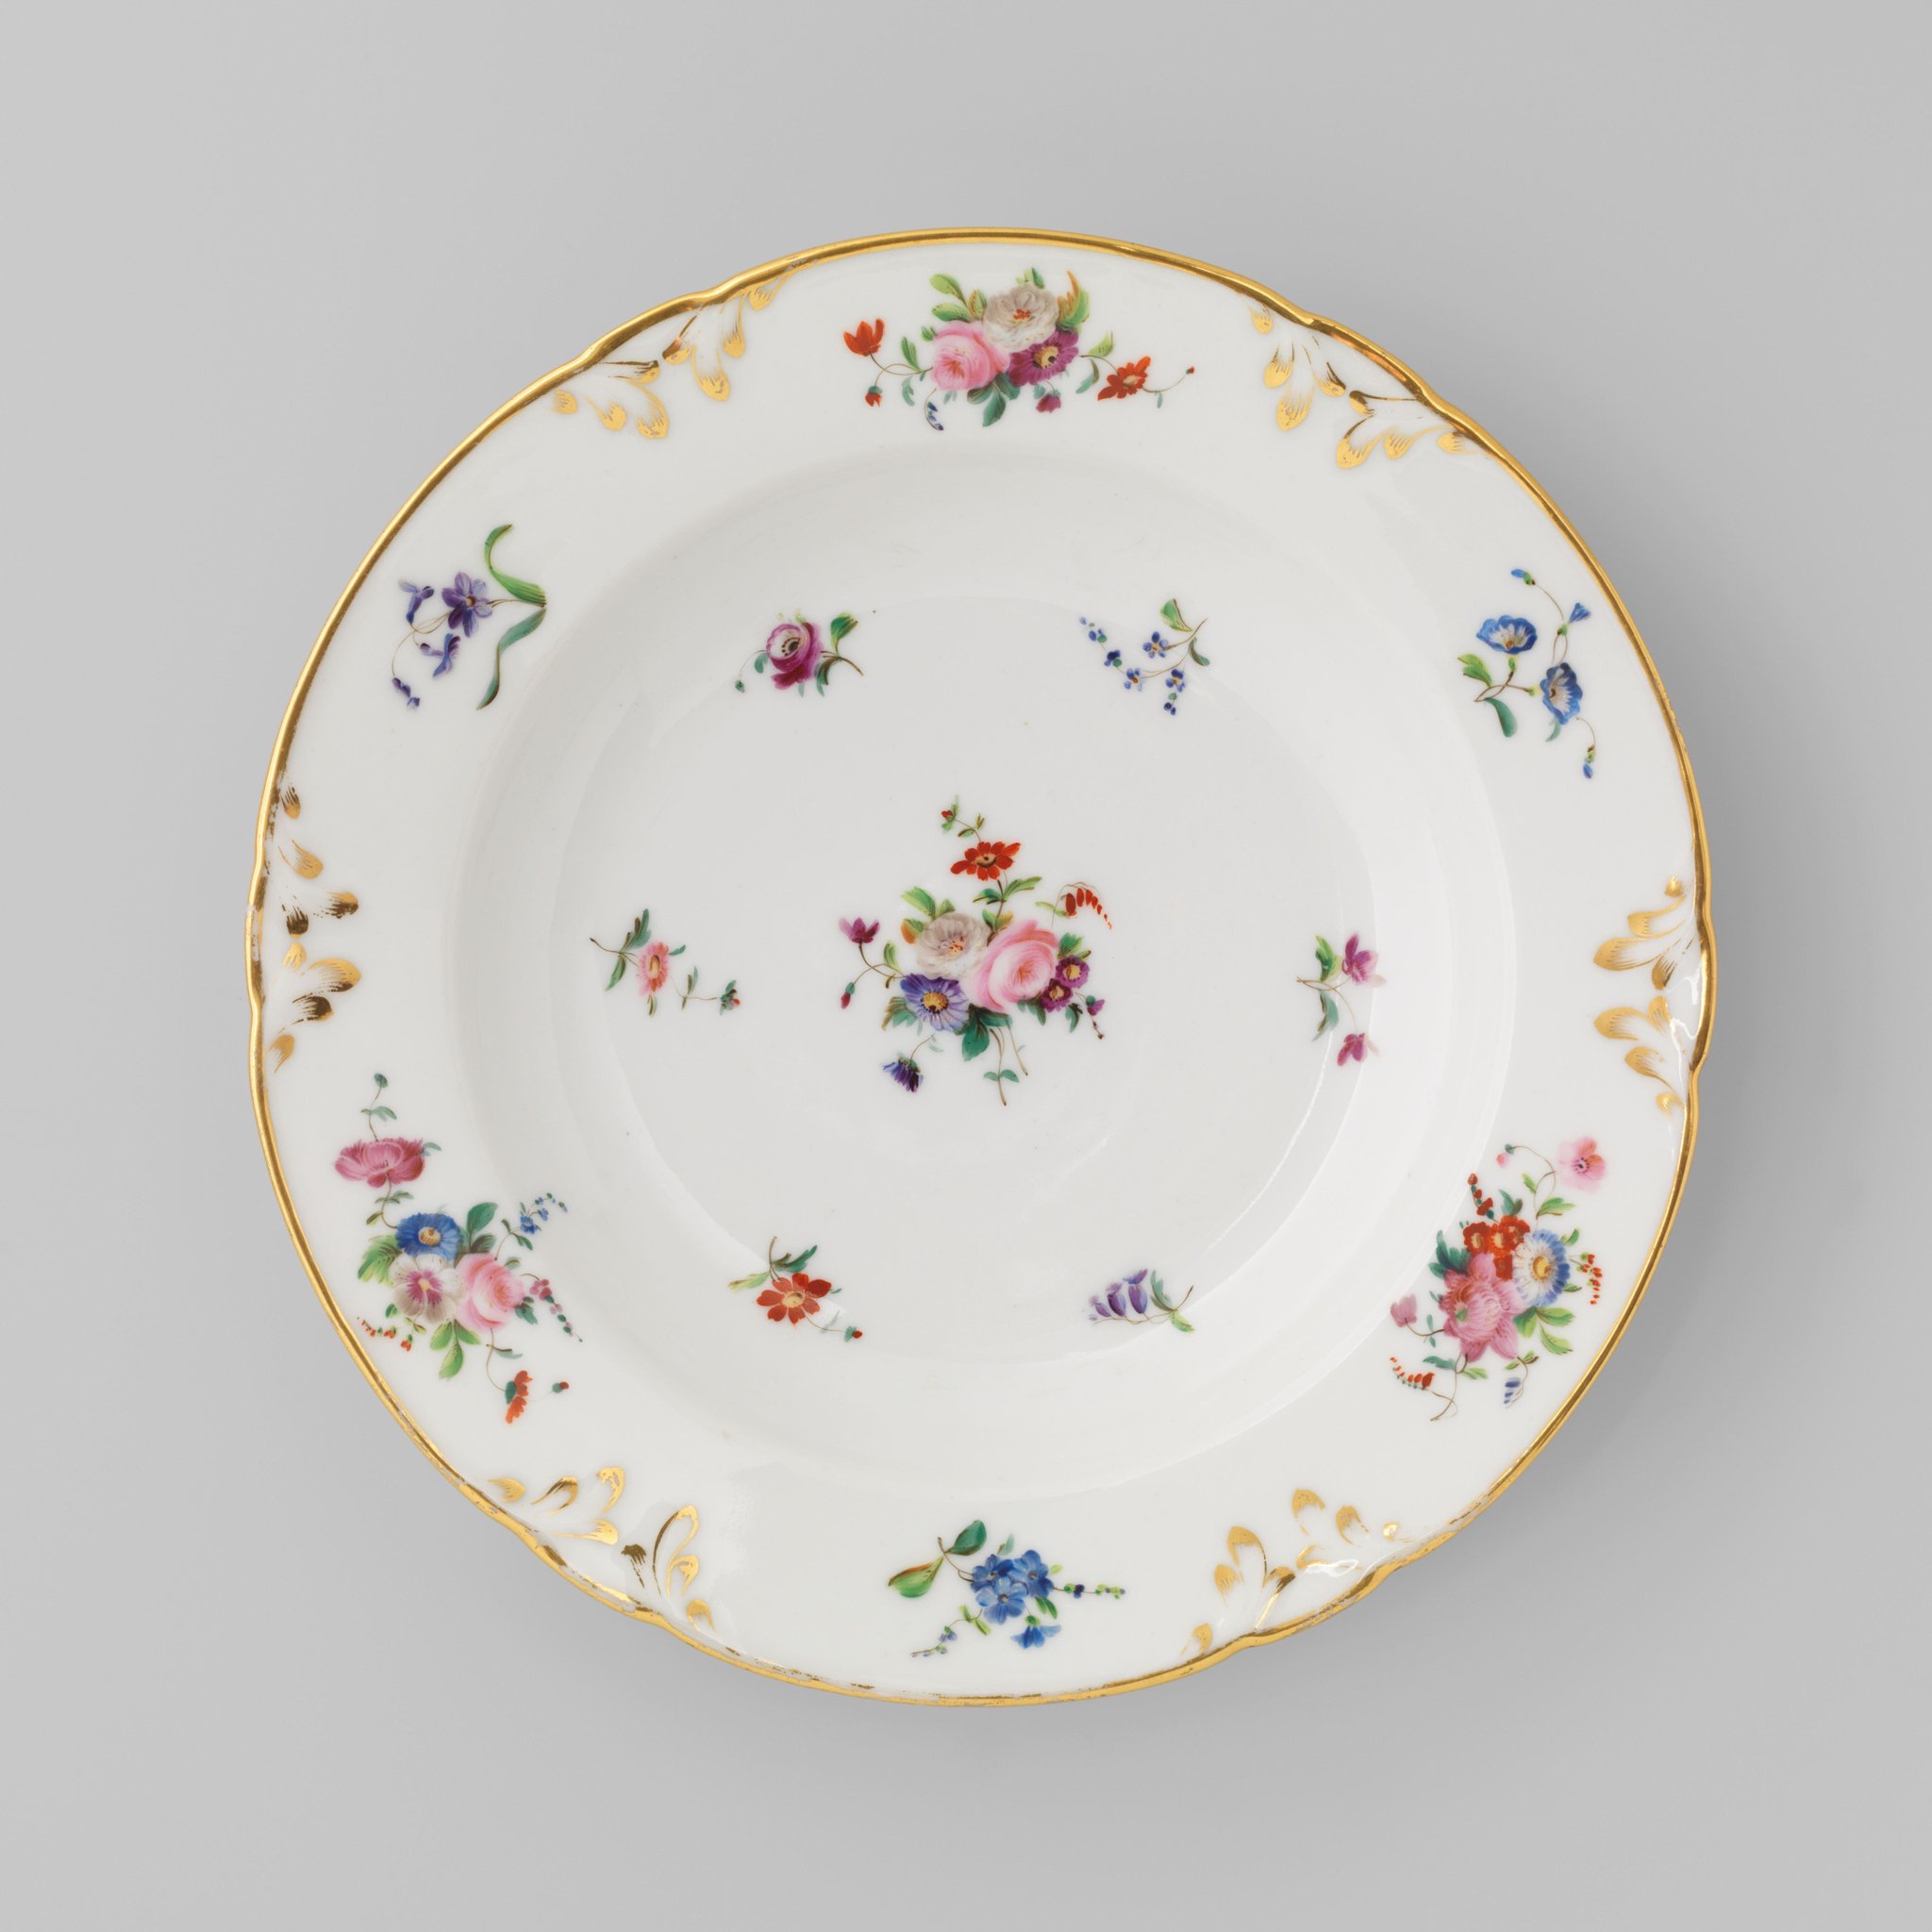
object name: service set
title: Plate with bouquets and flower sprays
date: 1839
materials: glaze, gold, paint, porcelain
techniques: firing, forming, gilding, turning, vitrification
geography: paris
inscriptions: mark: ‘DENUELLE/ Boulevard St. Denis 18/ à Paris’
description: Diep bord van porselein met een gelobde rand, beschilderd op het glazuur in blauw, rood, roze, groen, geel, paars, zwart en goud. Op het plat boeketten van verschillende bloemen en strooibloemen. Vanuit de gelobde, gouden rand, gemodelleerde bladranken in reliëf, aangezet met goud. Hiertussen boeketten. Drie proenen op de onderzijde. Gemerkt op de onderzijde met 'DENUELLE/ Boulevard St. Denis 18/ à Paris'.